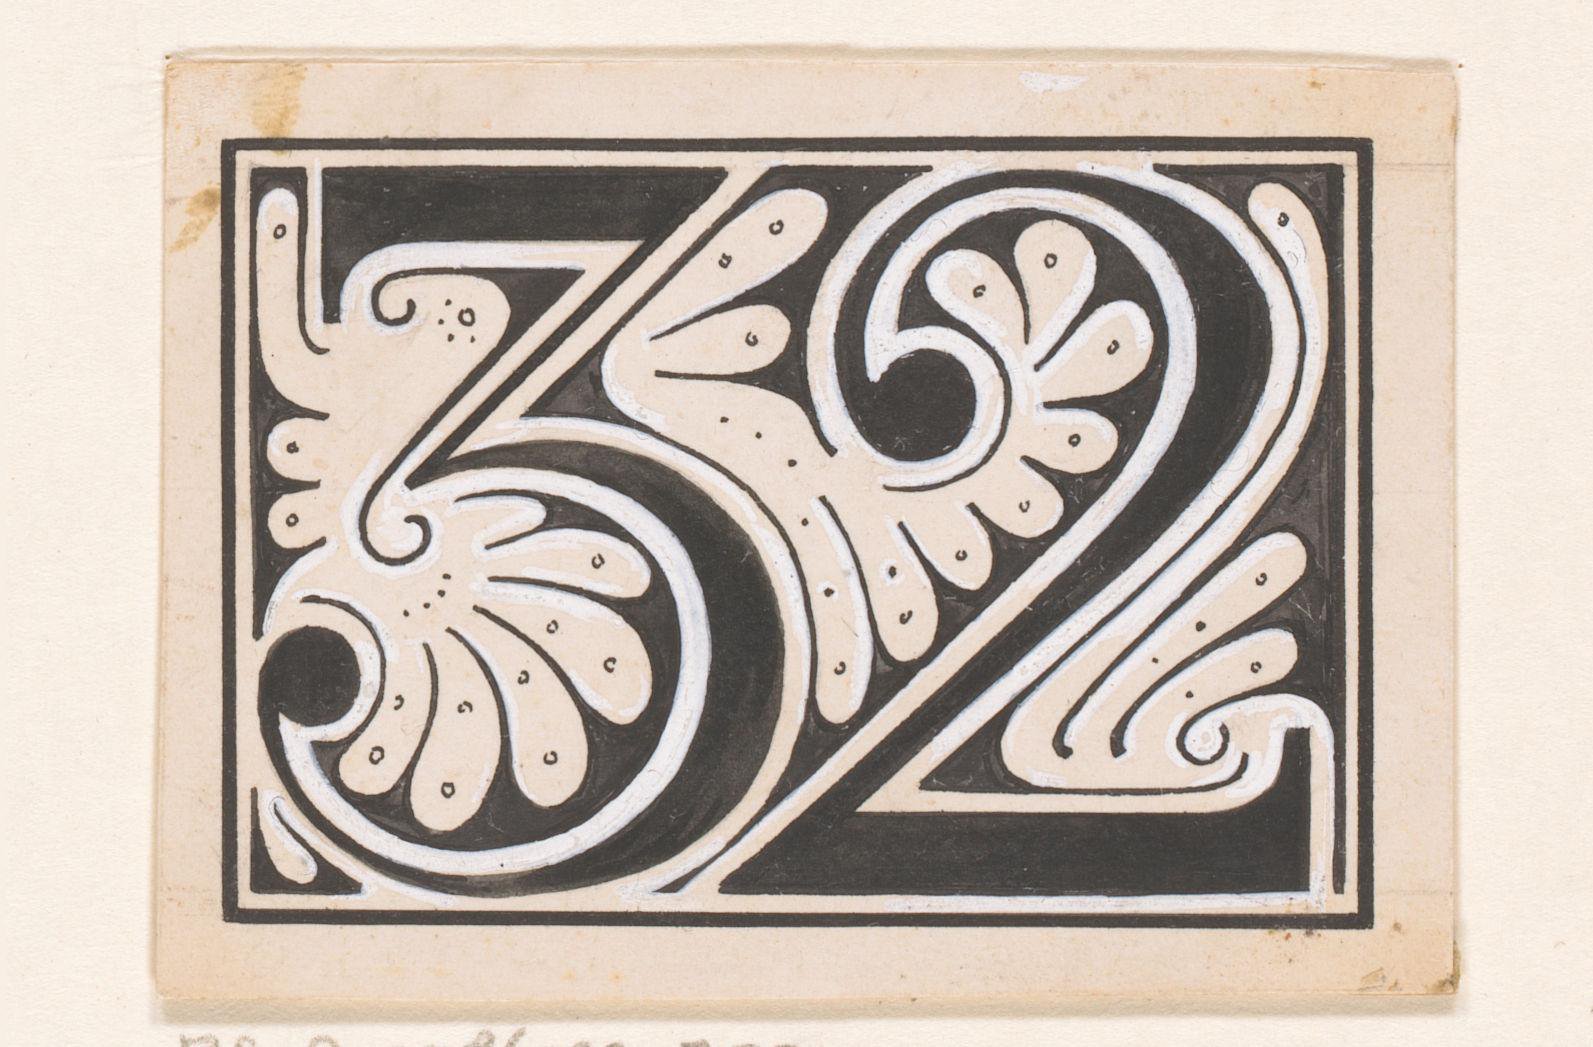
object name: design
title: Getal 32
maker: reinier willem petrus de vries (1874-1953)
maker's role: draughtsman, print maker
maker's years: 1874-1953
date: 1904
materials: paint, ink, paper, pencil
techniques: brush, pen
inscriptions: collector's mark: ‘R:MVS.’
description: Het getal is gebruikt voor: Veth, Jan. Jozef Israëls en zijn kunst. Arnhem en Nijmegen: Gebroeders E&M Cohen, 1904.